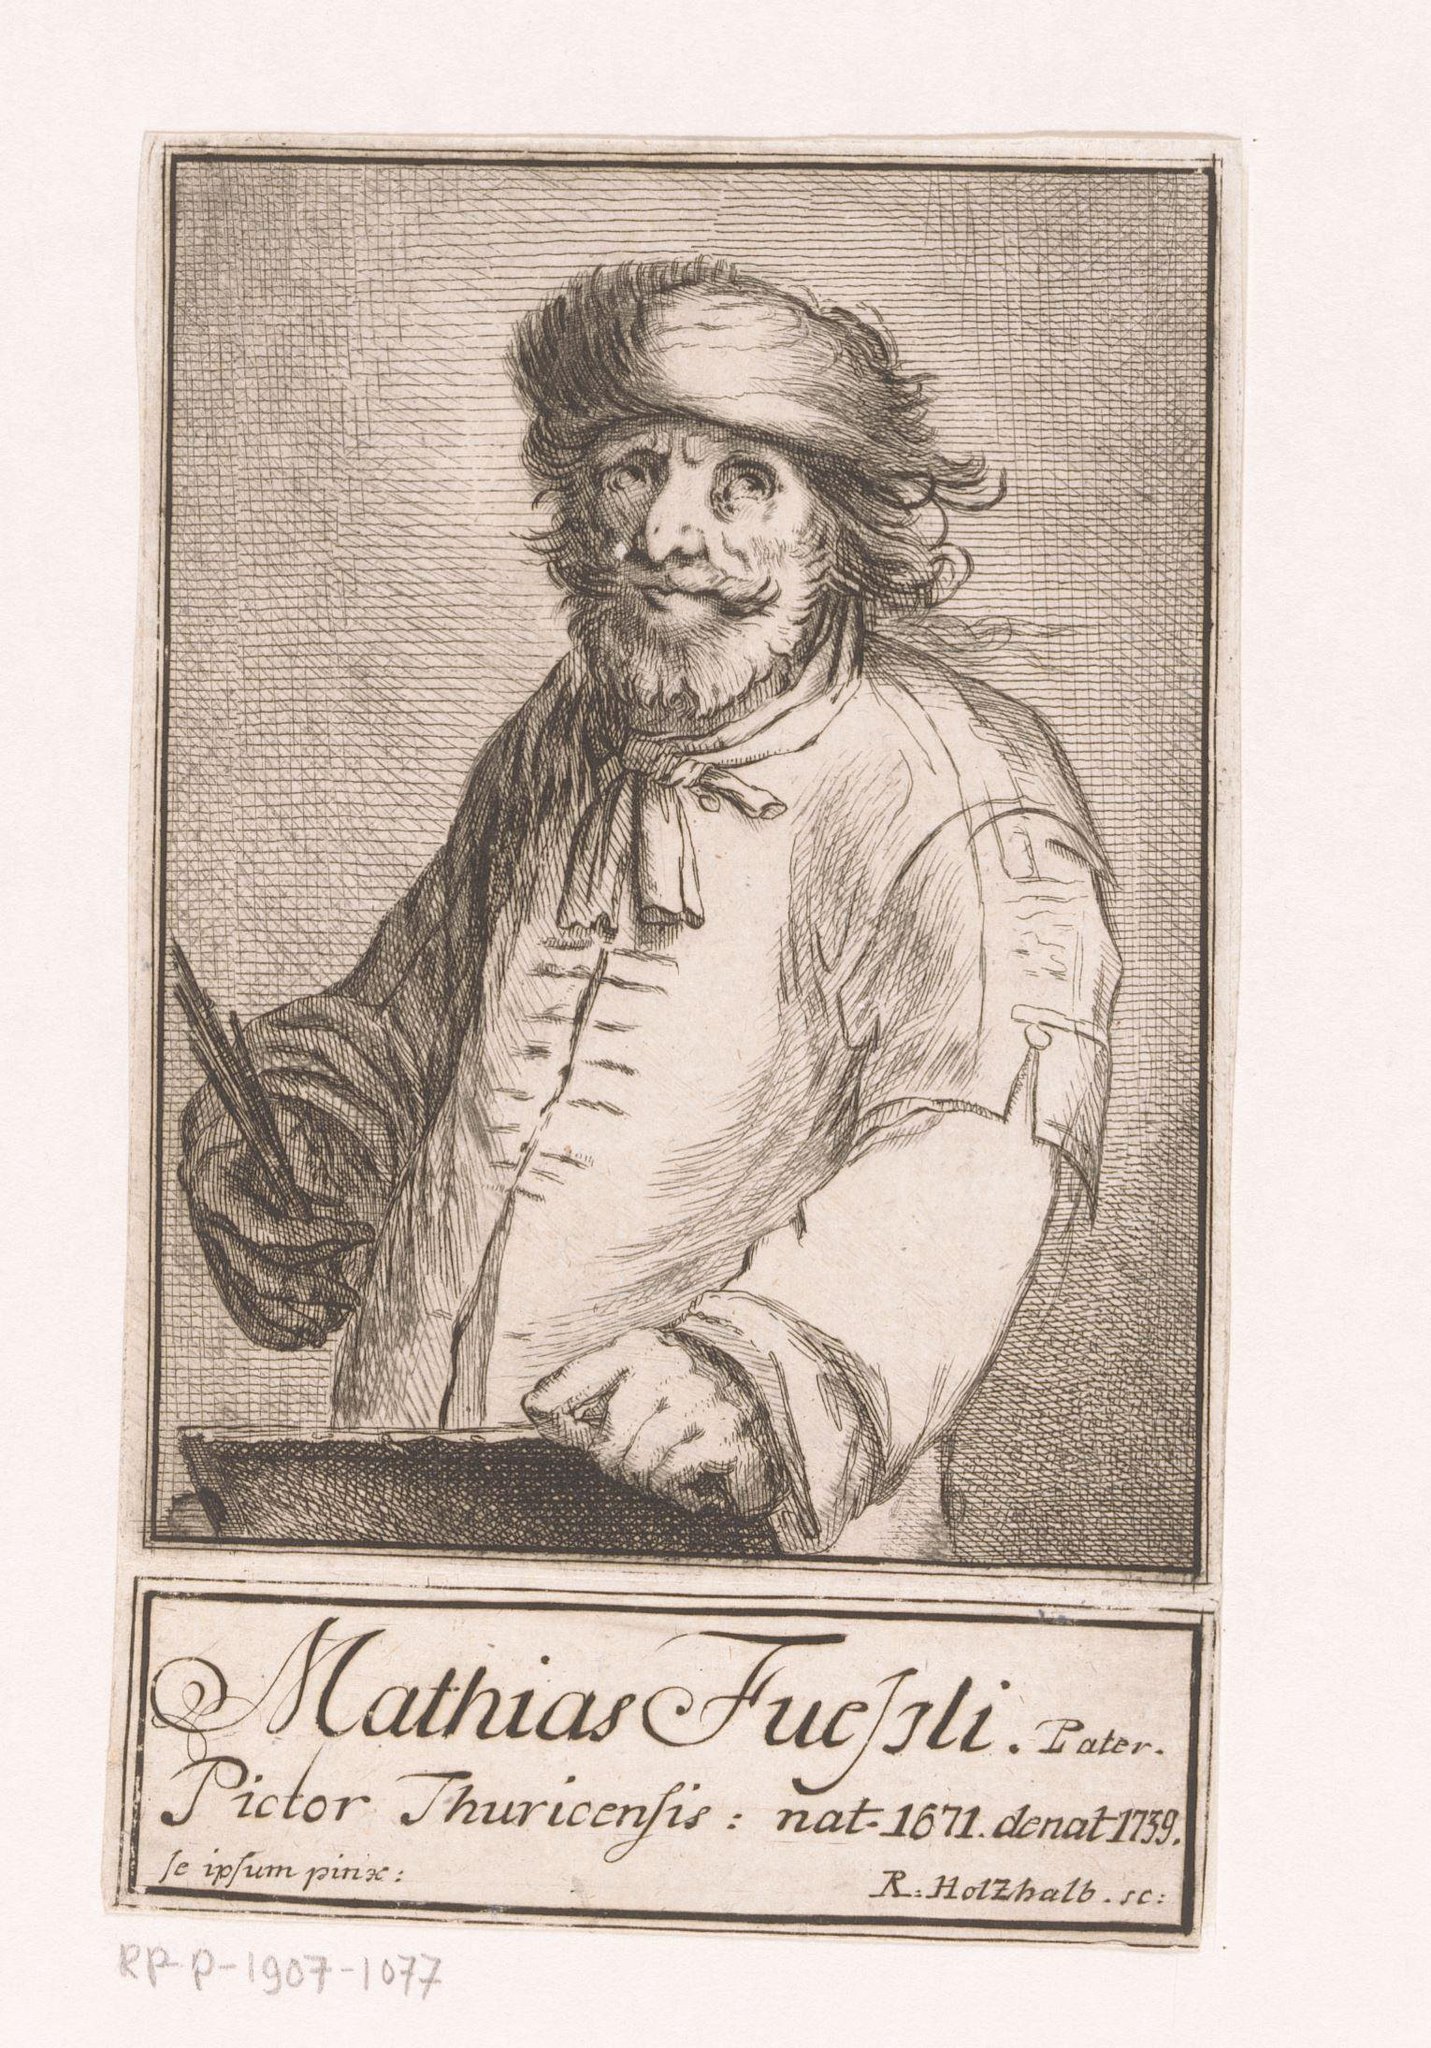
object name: print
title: Portret van Mathias Füssli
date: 1733-1806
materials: paper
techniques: etching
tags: mathias füssli (iii), historical persons, portrait, self-portrait of artist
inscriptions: collector's mark: Lugt 2228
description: Portret naar een zelfportret van Matthias Füssli met penselen in de rechterhand. Daaronder een kader met Füssli's geboorte- en sterfdatum.